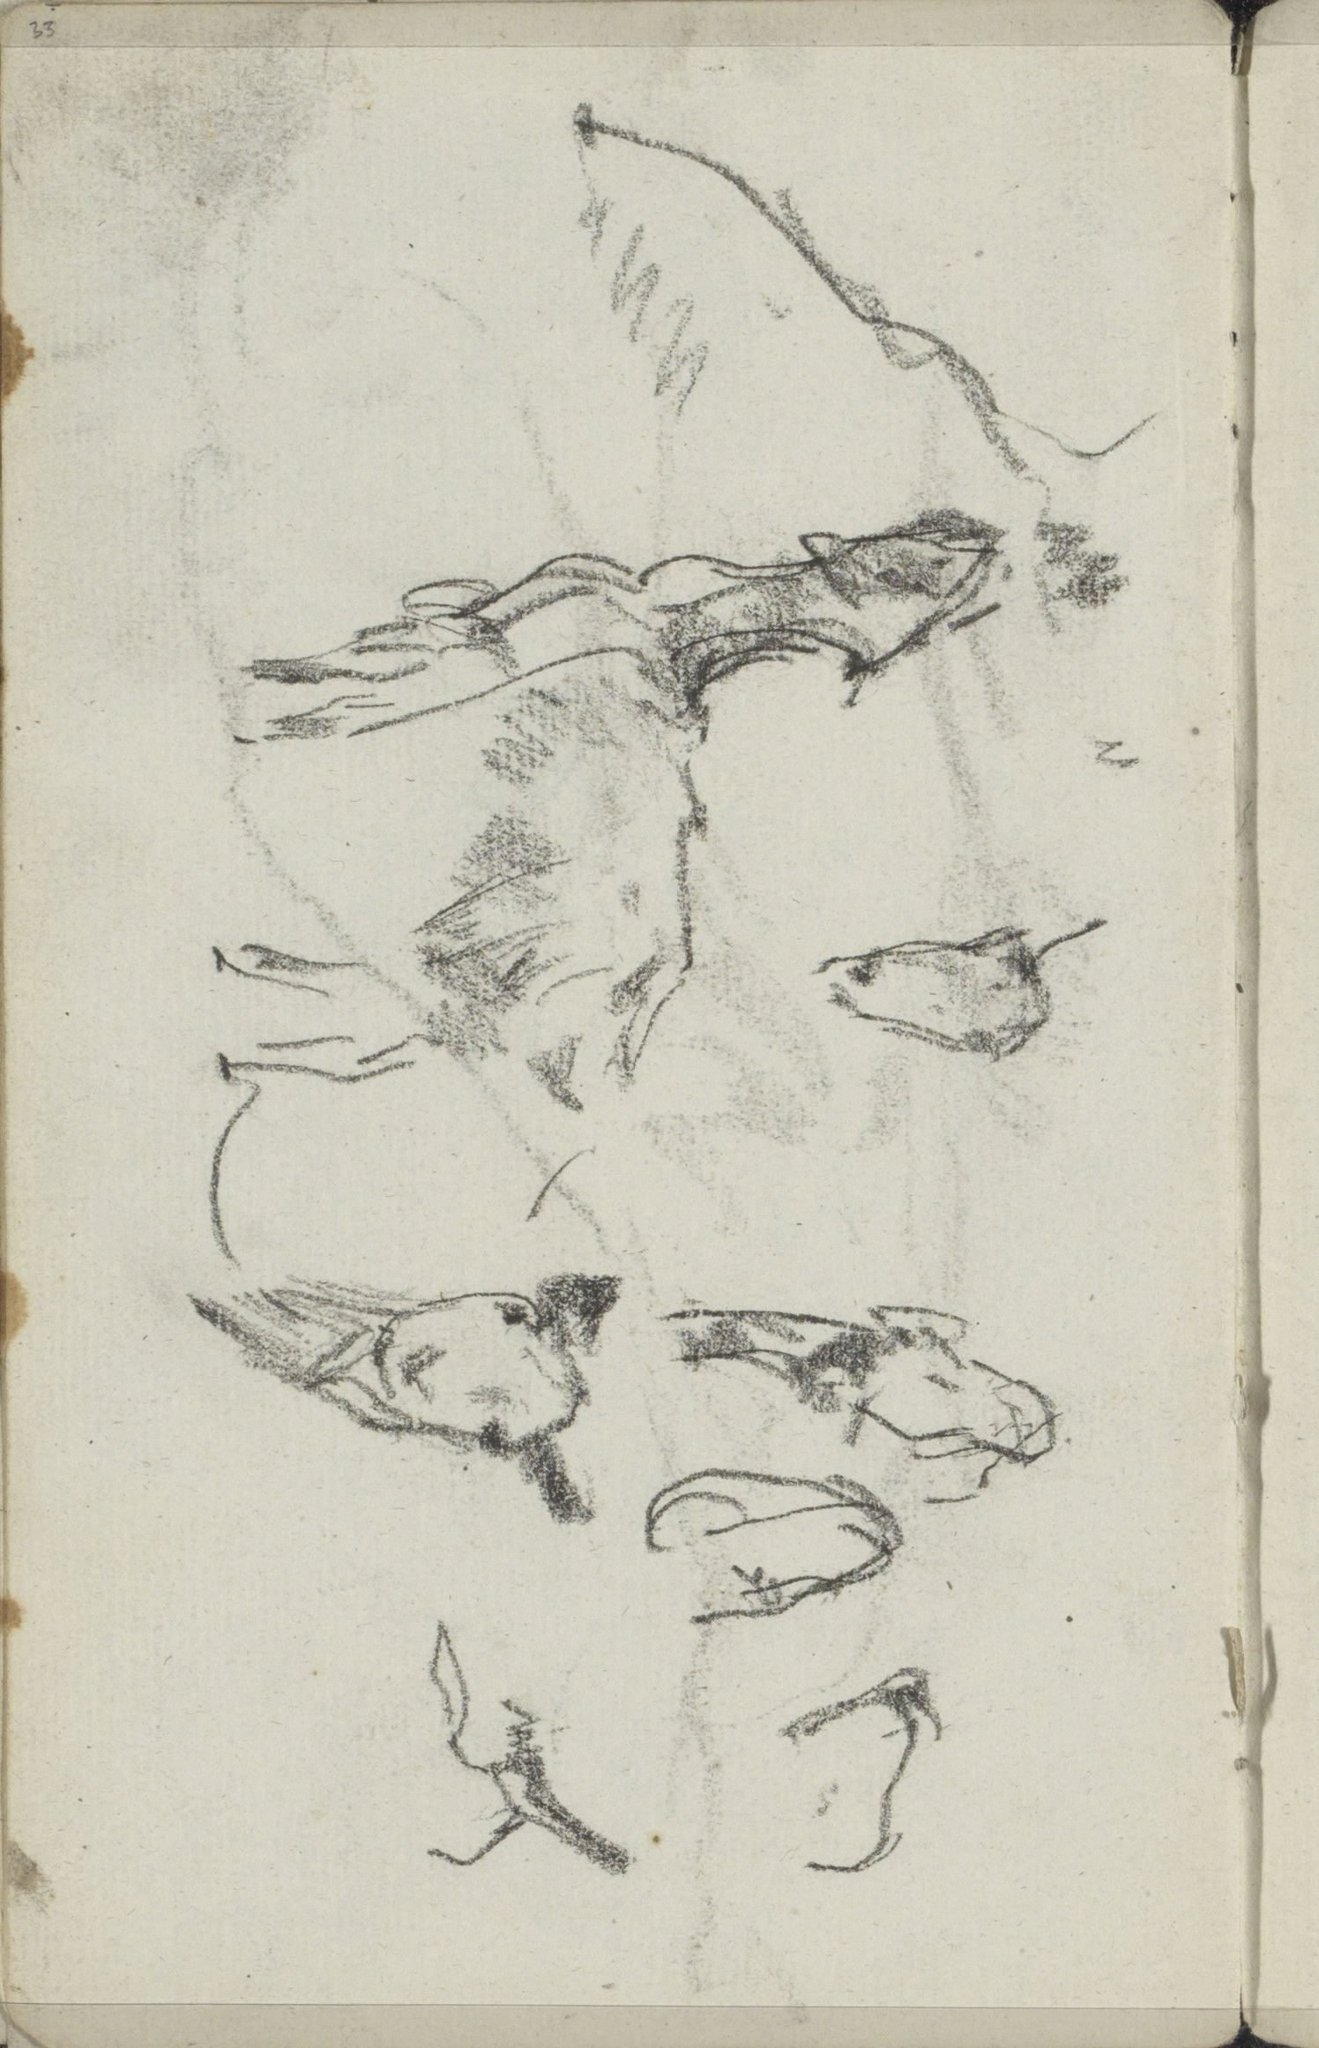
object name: sketchbook leaf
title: Geiten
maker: george hendrik breitner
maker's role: draughtsman, painter, print maker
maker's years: 1857-1923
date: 1883-1885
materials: chalk, paper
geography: the hague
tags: goat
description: Pagina 33 uit een schetsboek met 17 bladen.